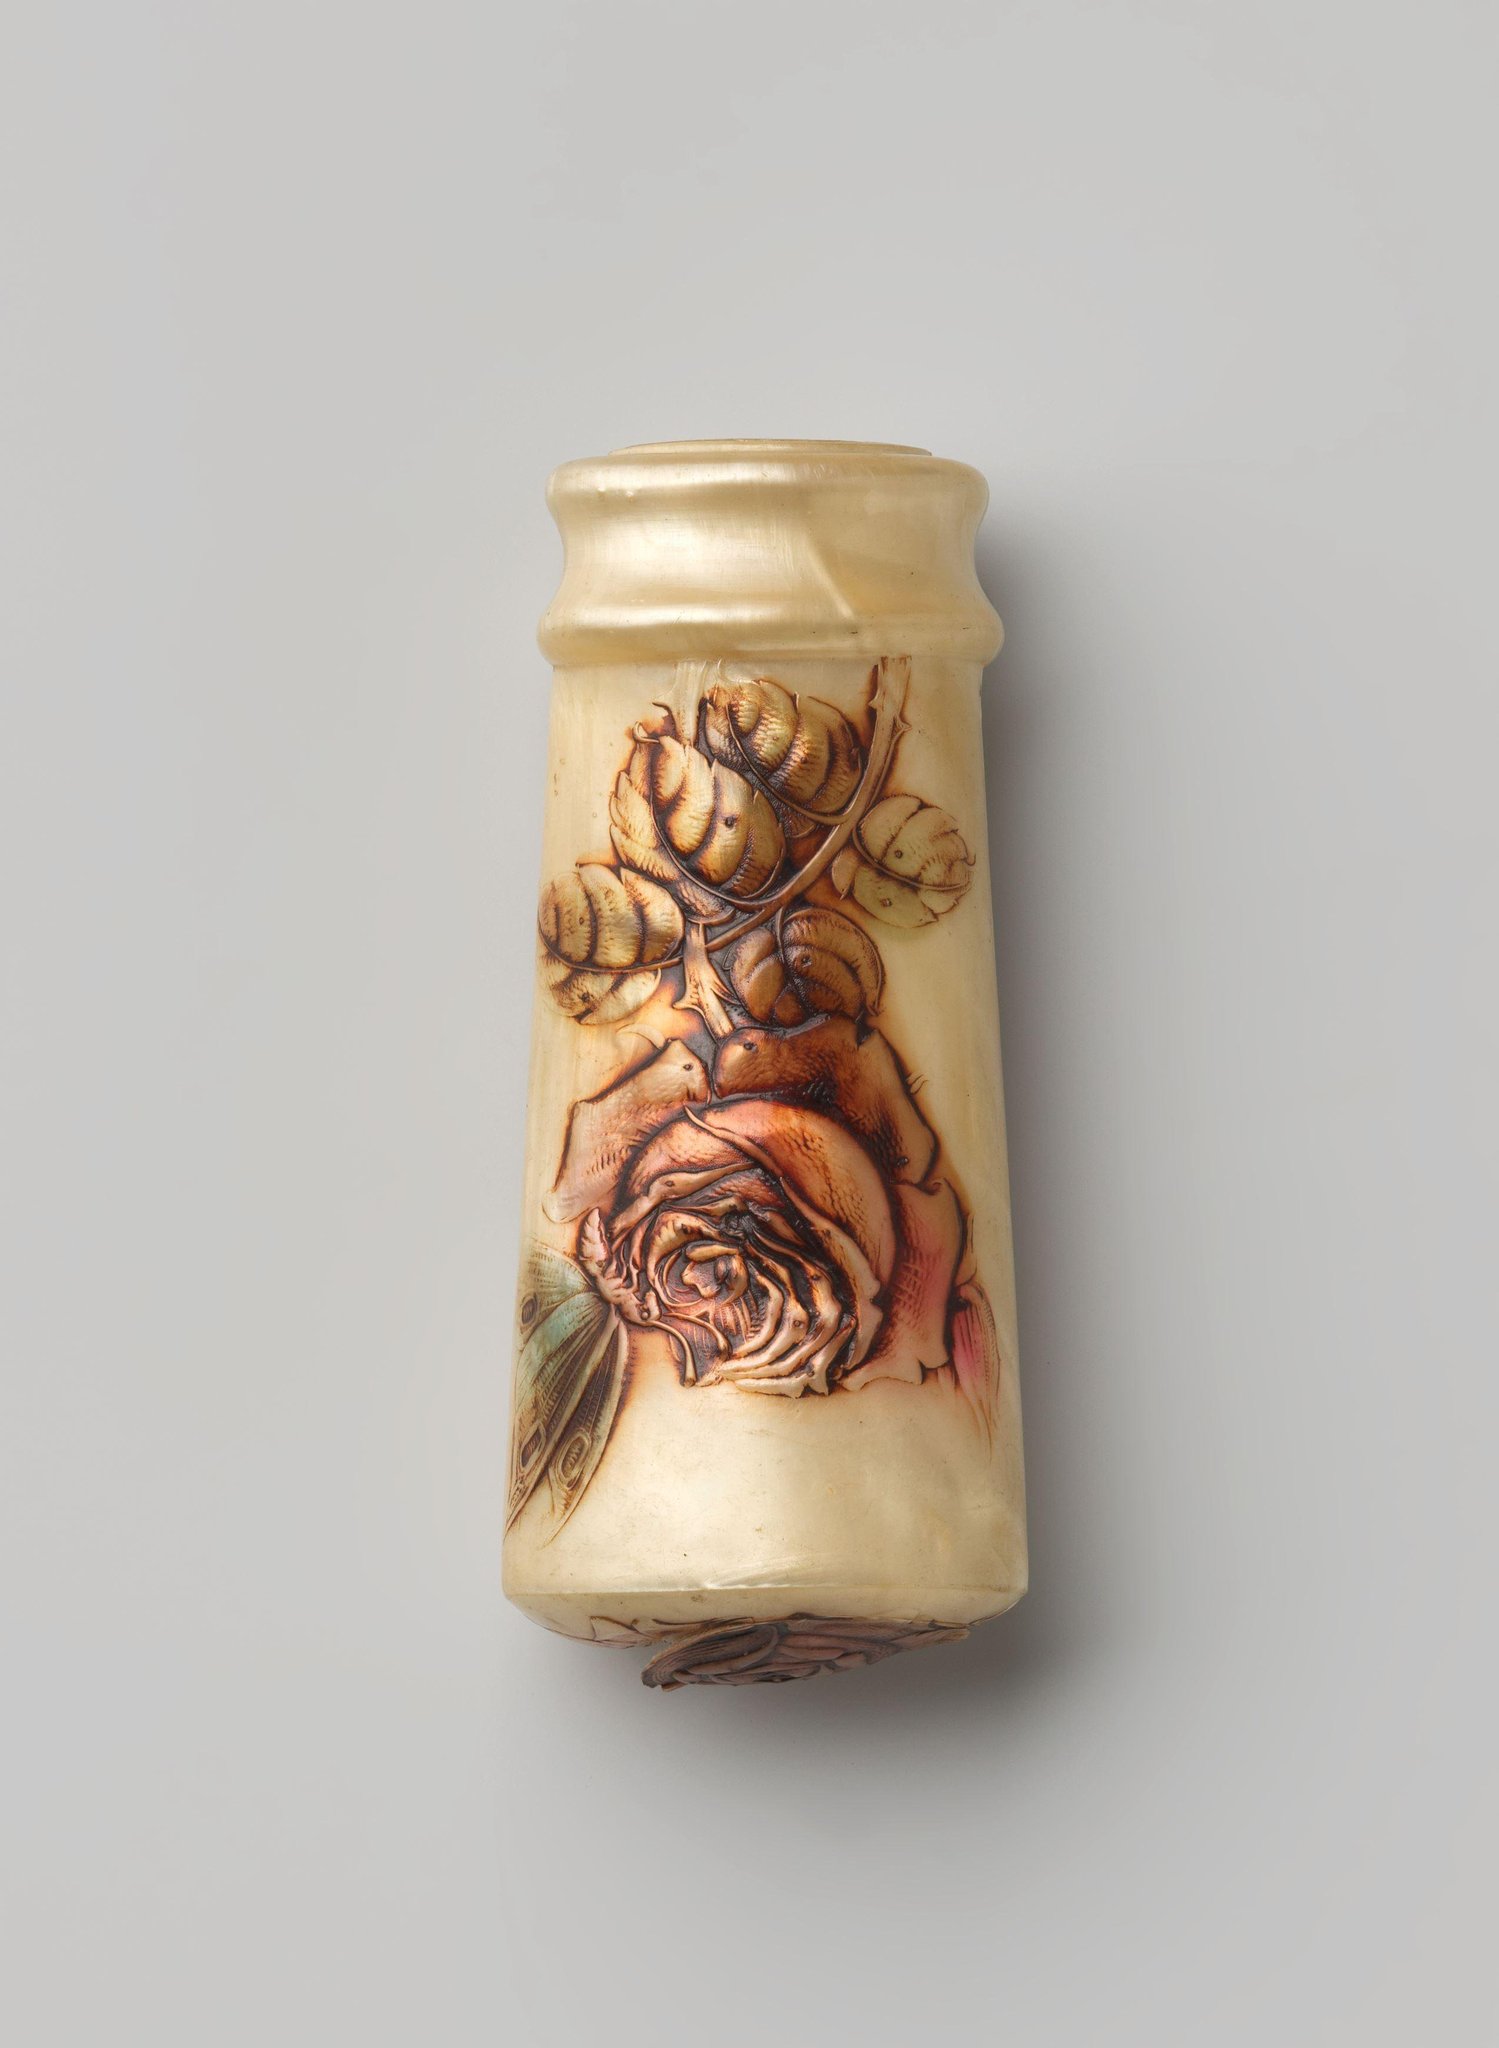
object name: handle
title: Konische parasolknop of parapluknop van celluloid met parelmoerglans, versierd met gesneden rozen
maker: gustav schnitzler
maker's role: paraplufabrikant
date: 1920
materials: celluloid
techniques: cutting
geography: nijmegen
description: Konische parasolknop of parapluknop van celluloid met parelmoerglans, versierd met gesneden rozen.